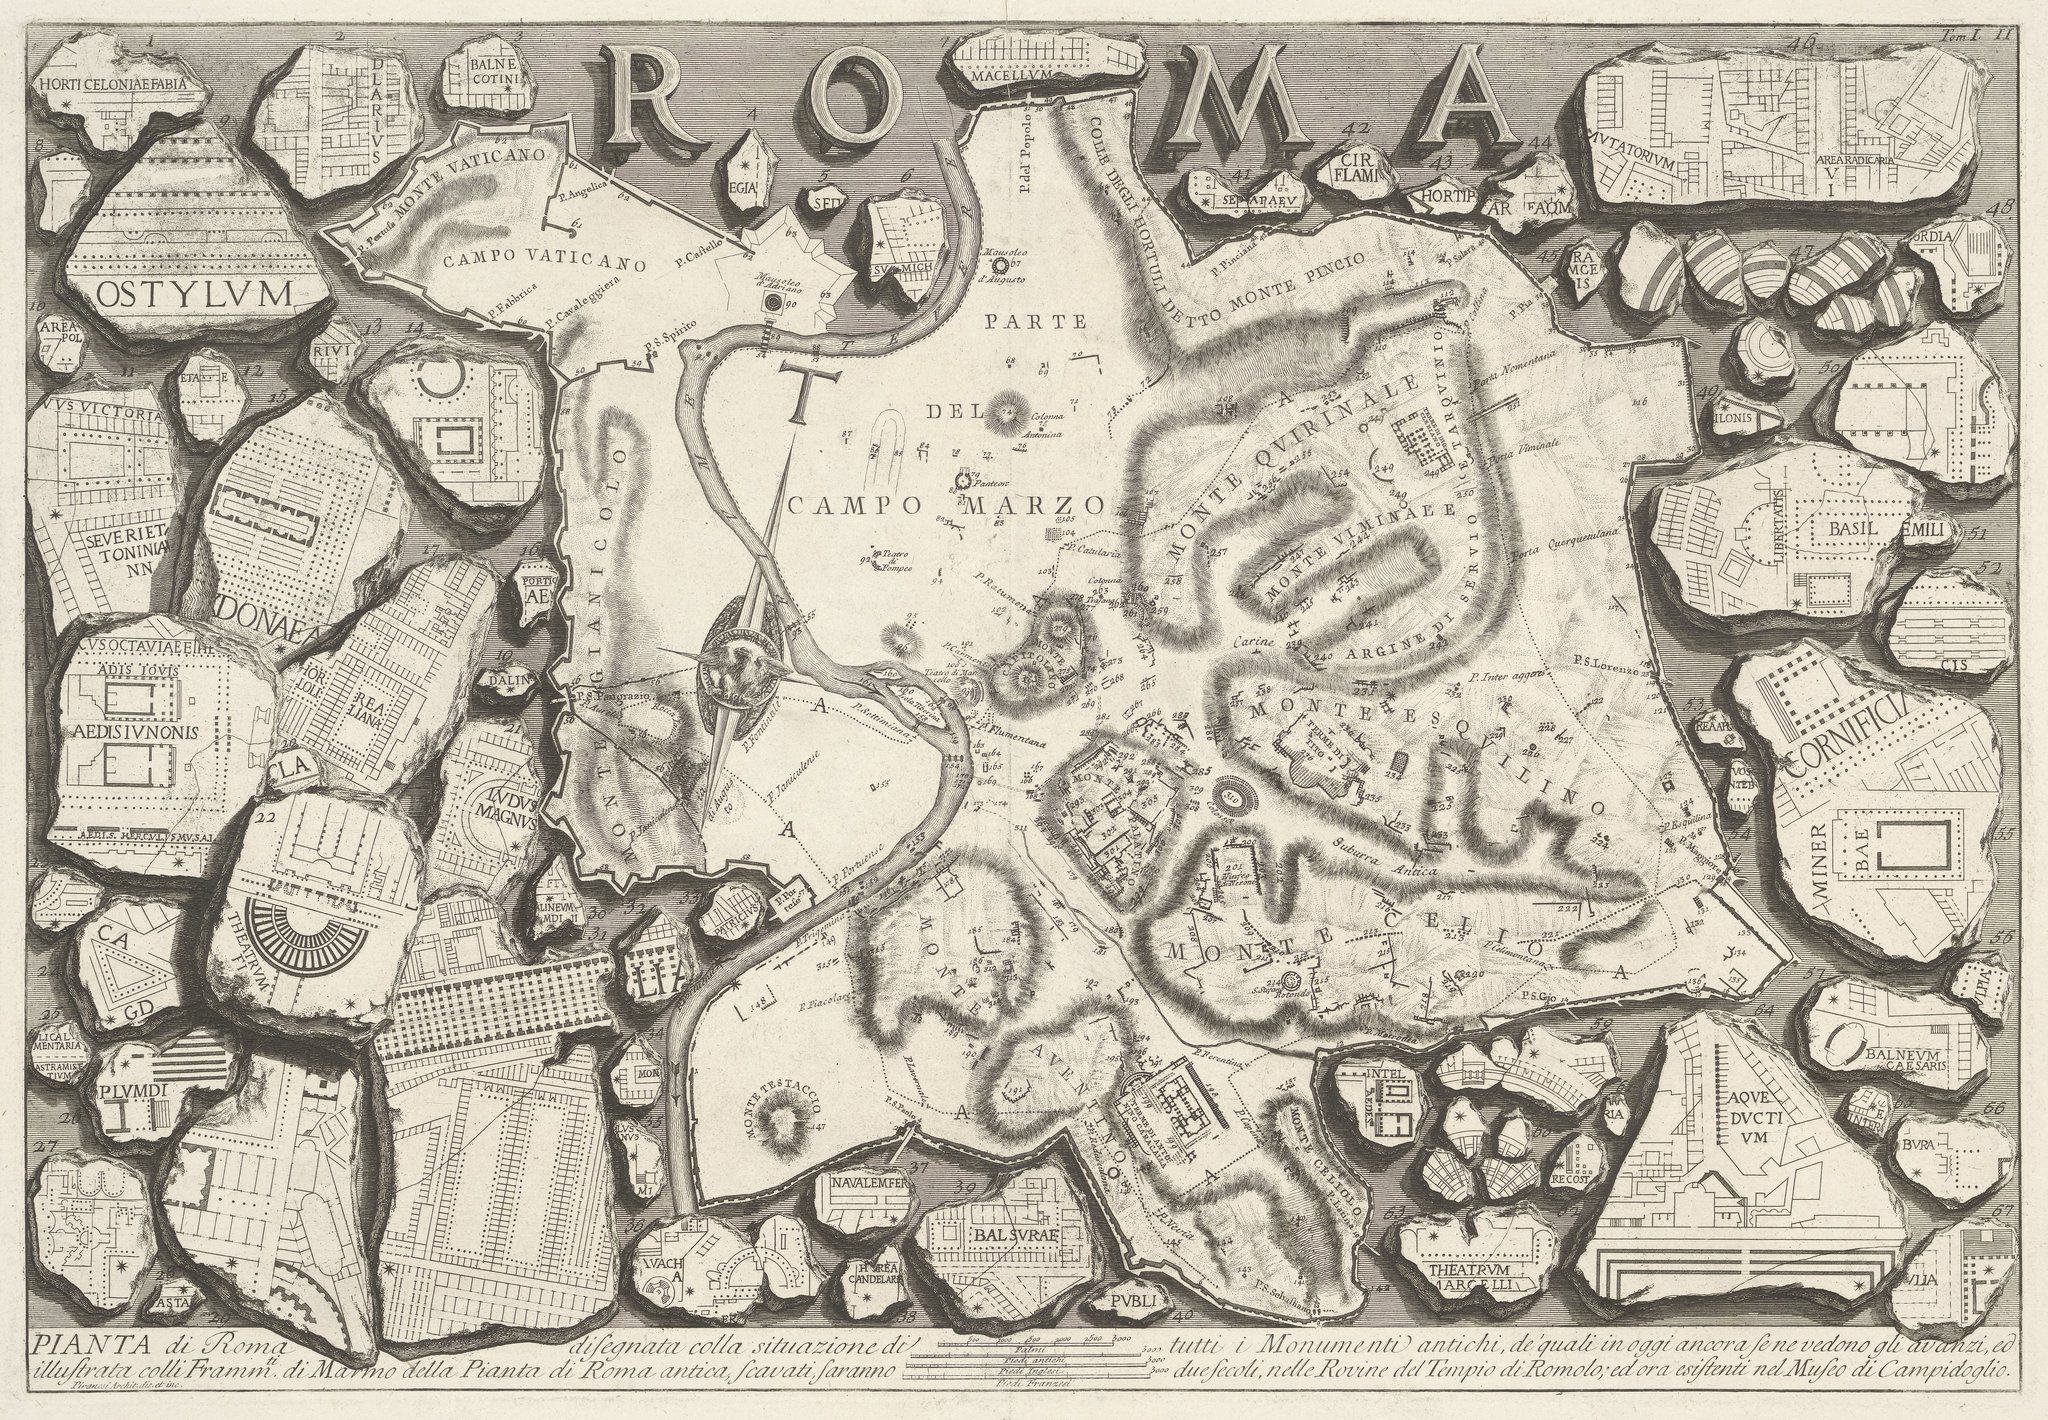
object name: print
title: Le Antichità Romane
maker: giovanni battista piranesi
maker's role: designer, draughtsman, print maker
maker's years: 1720-1778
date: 1756-1757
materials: paper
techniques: etching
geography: rome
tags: maps, atlases, rome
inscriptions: collector's mark: Lugt 2228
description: Deze prent maakt deel uit van de serie 'Le Antichità Romane'. Piranesi deed meer dan acht jaar voorstudie voor deze 250 platen tellende serie die in vier volumes werd uitgegeven. Hij produceerde de prenten tussen ca. 1756 en 1757. De serie bevat ook prenten door of naar andere prentmakers, onder wie Francesco Bianchini en Girolamo Rossi.